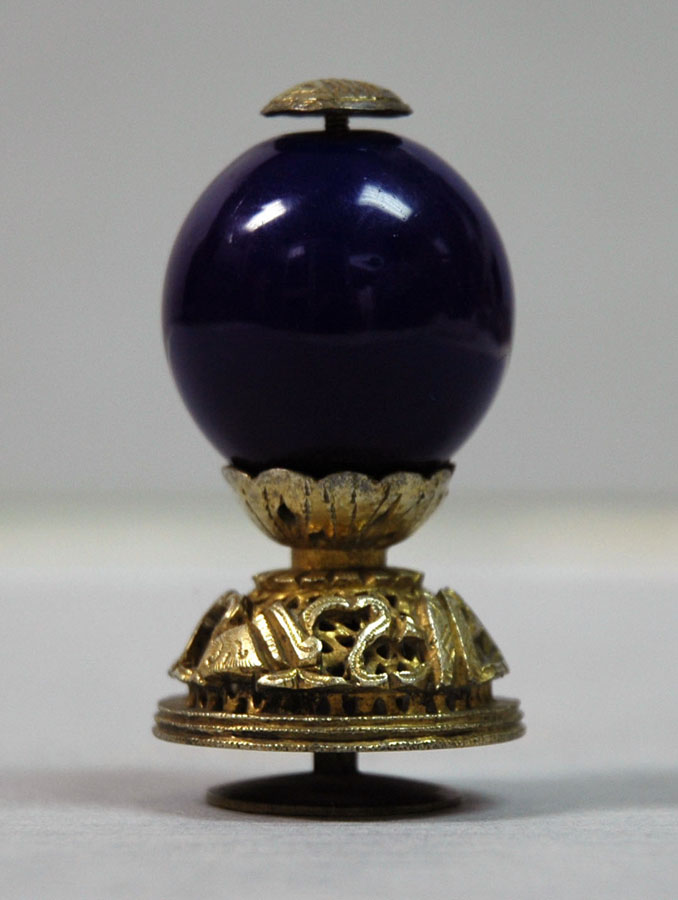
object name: hat finial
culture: chinese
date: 1644-1911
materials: glass, metal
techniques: gilding